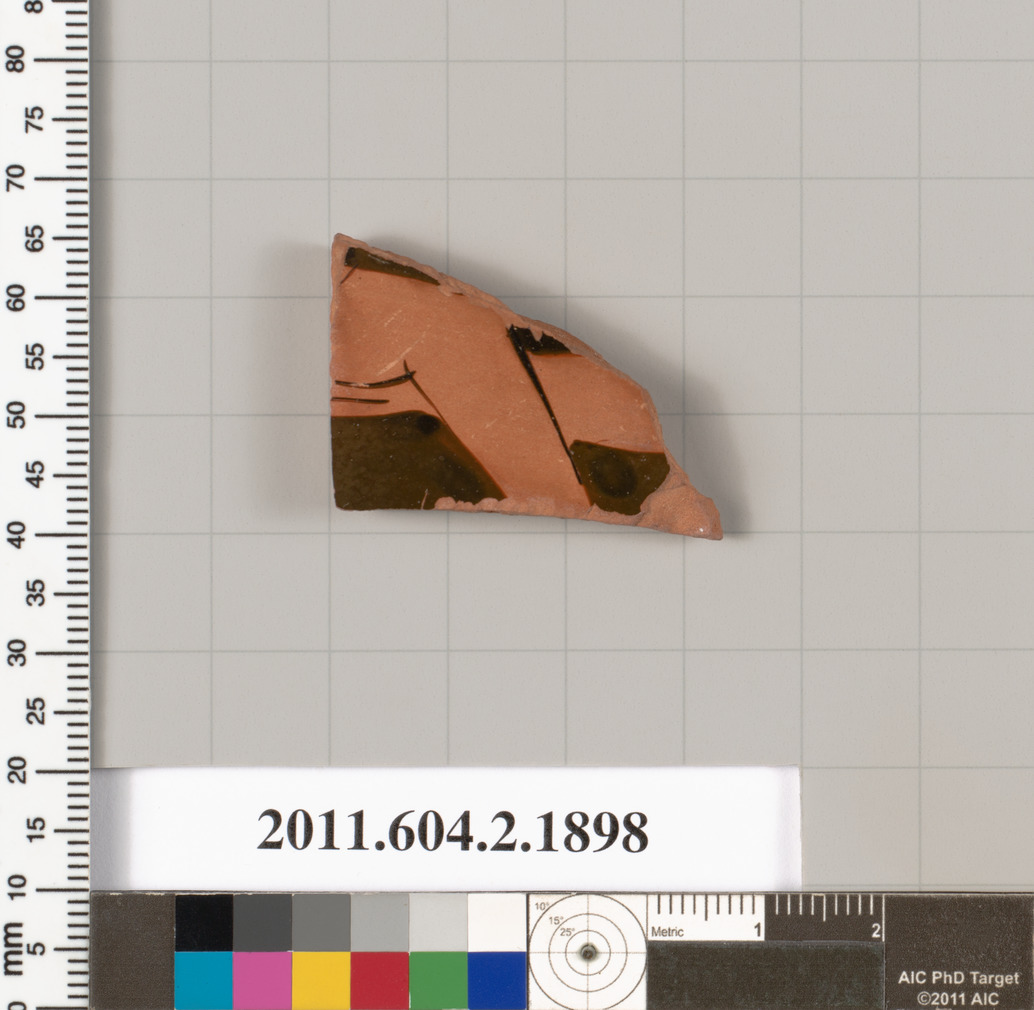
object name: skyphos fragment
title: Terracotta fragment of a skyphos (deep drinking cup)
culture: greek, attic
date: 430-400 BCE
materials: terracotta